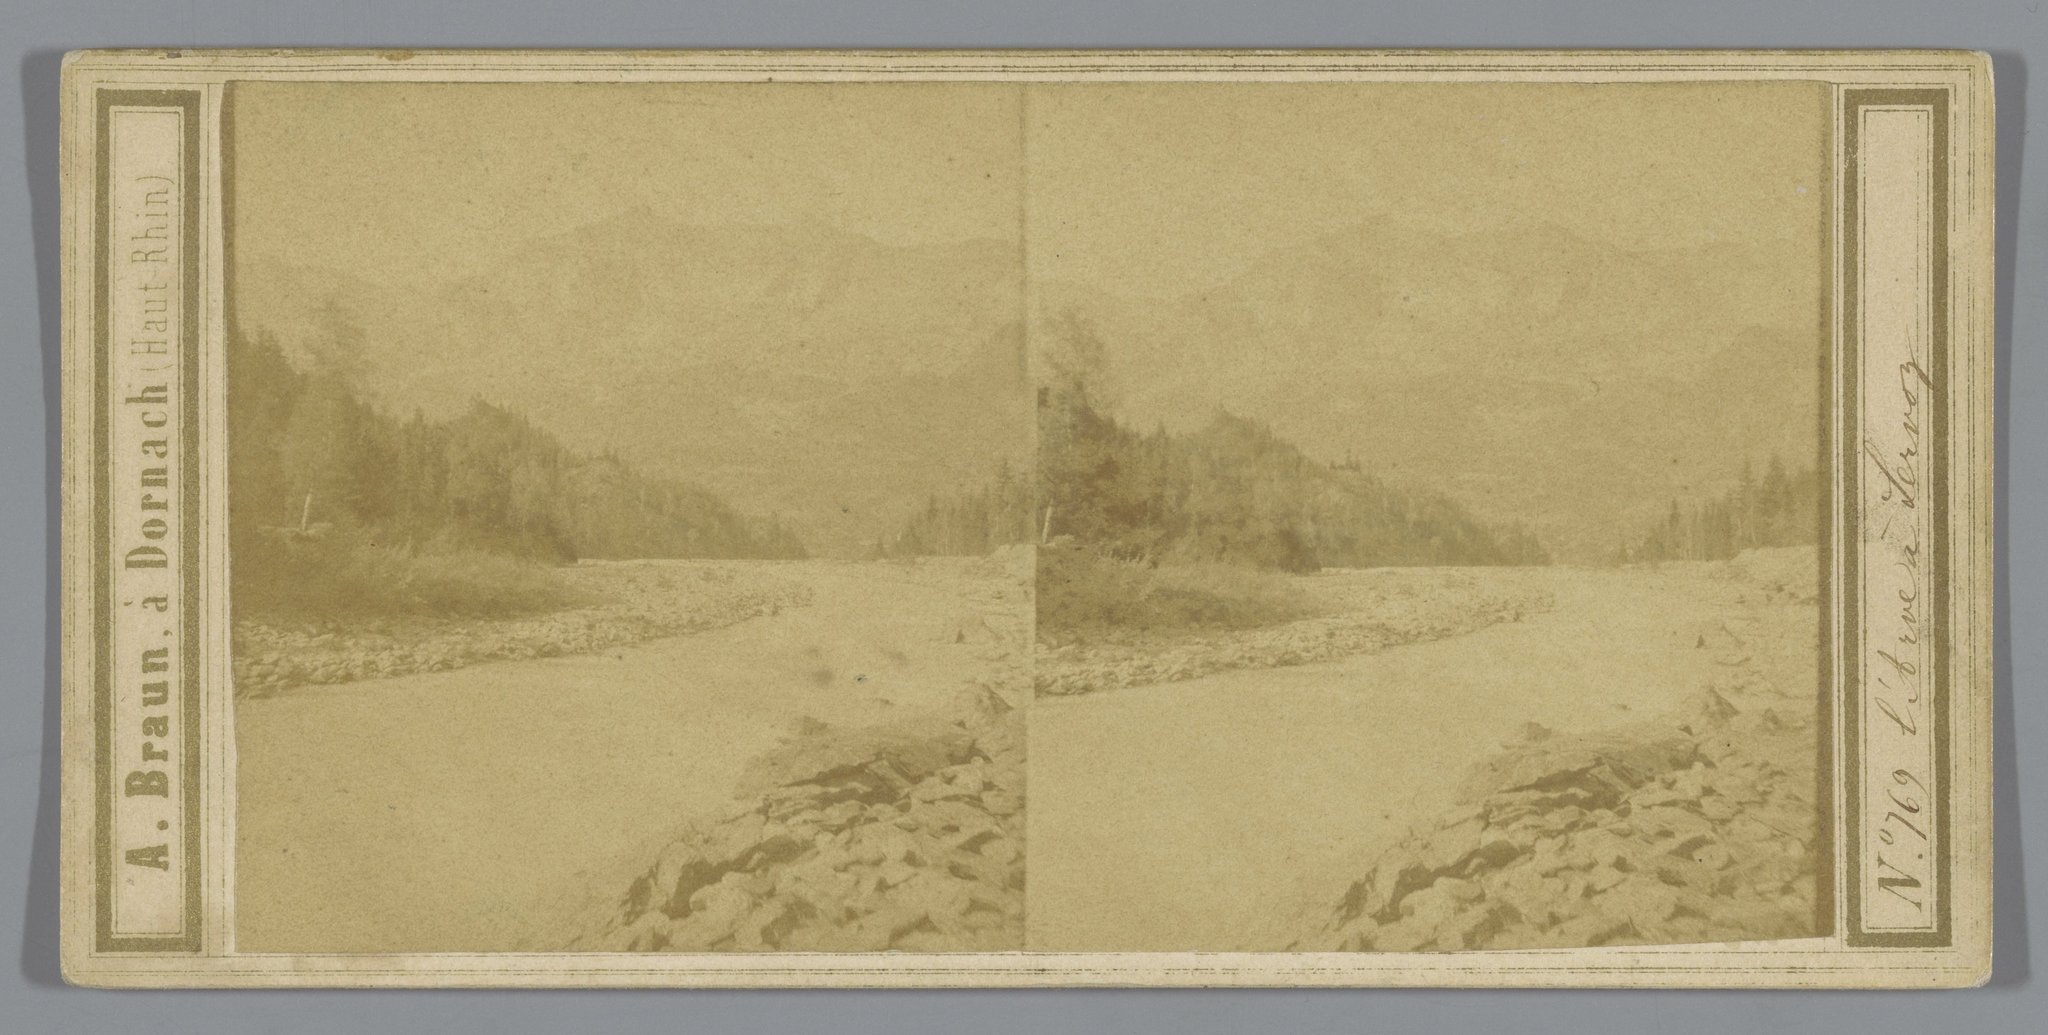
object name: stereograph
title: Gezicht op de Arve nabij Servoz, Frankrijk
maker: Anonymous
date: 1860-1866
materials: cardboard, paper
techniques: albumen print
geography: servoz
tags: river, mountain meadow, alp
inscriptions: number: ‘No. 769’, number: ‘No 16’